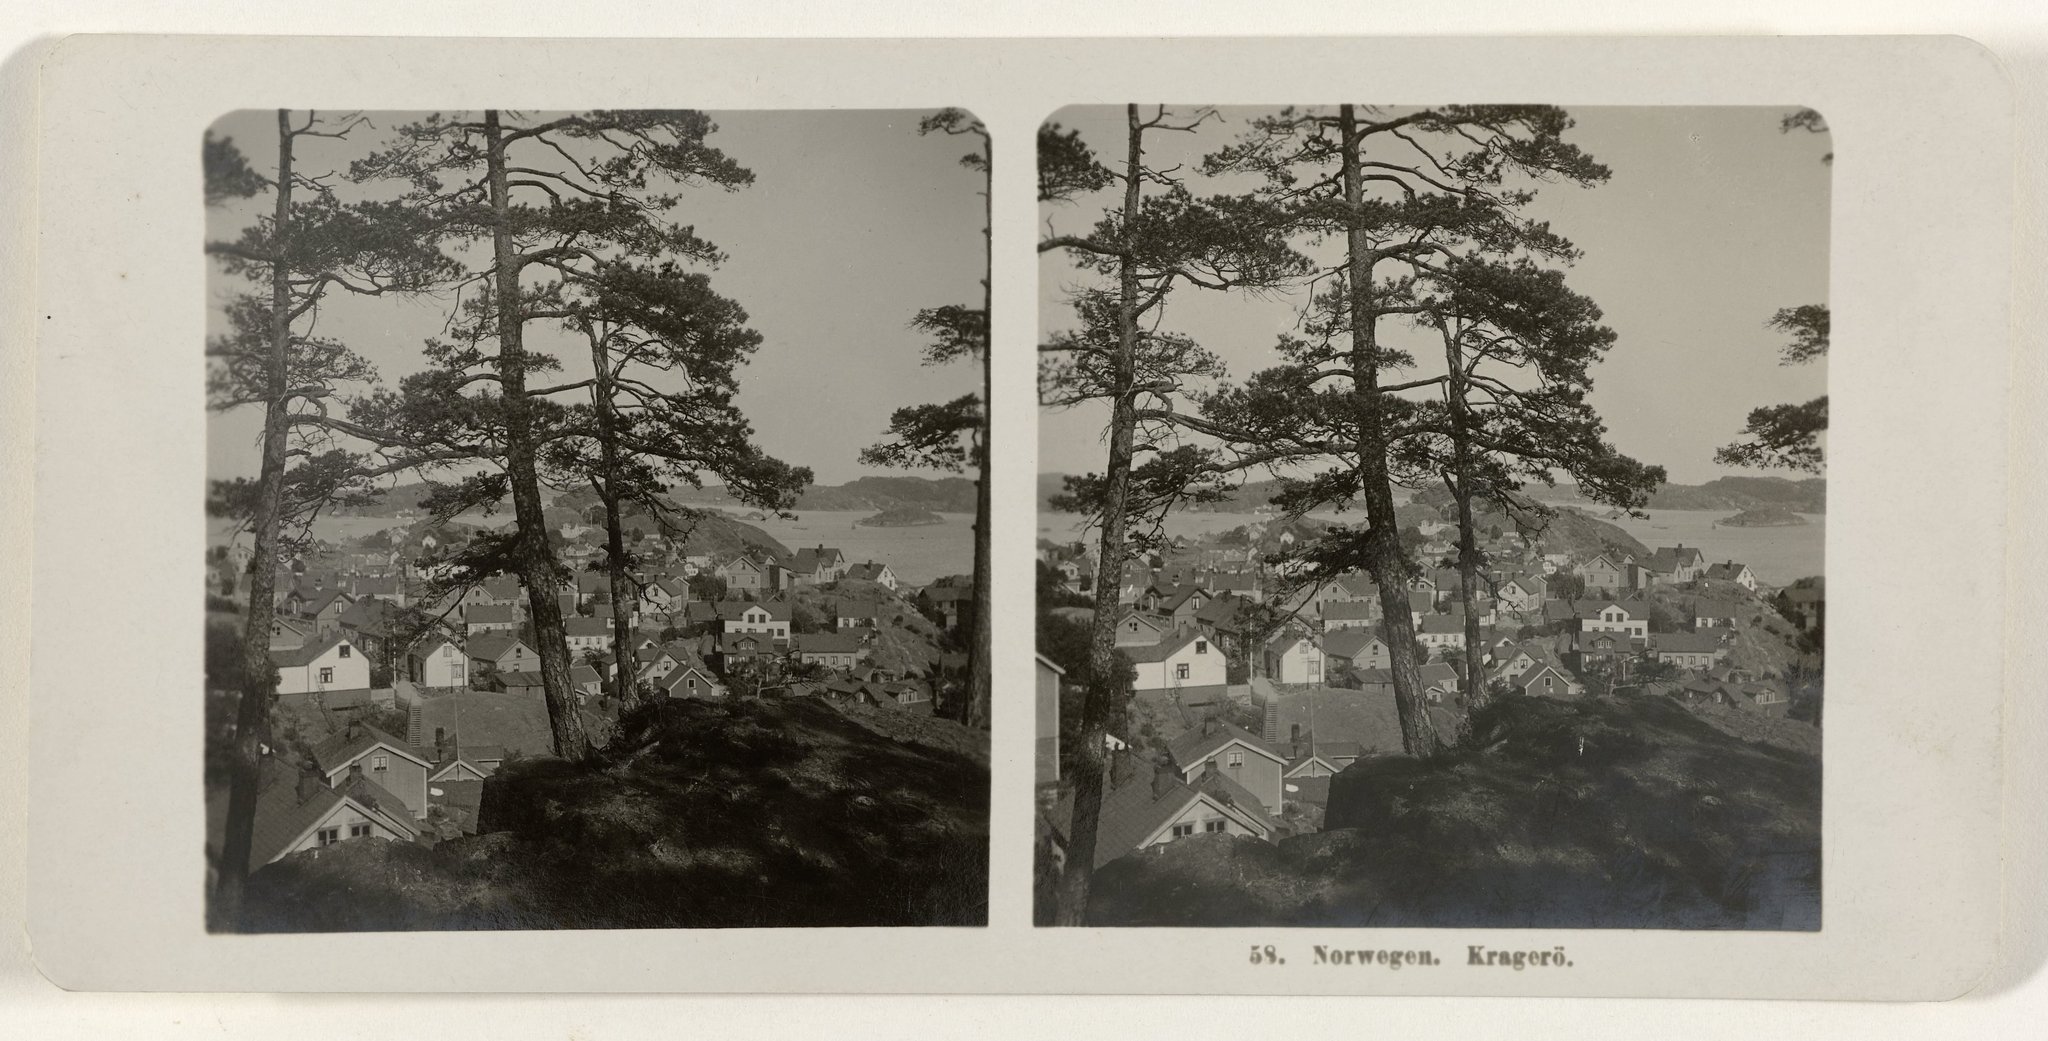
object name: stereograph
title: 58. Norwegen Kragero.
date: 1906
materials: paper, photographic support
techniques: collodion silver print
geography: norway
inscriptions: workshop stamp: ‘Neue Photographische Gesellschaft A.G. Steglitz - Berlin 1906’, title: ‘58. Norwegen Kragero.’